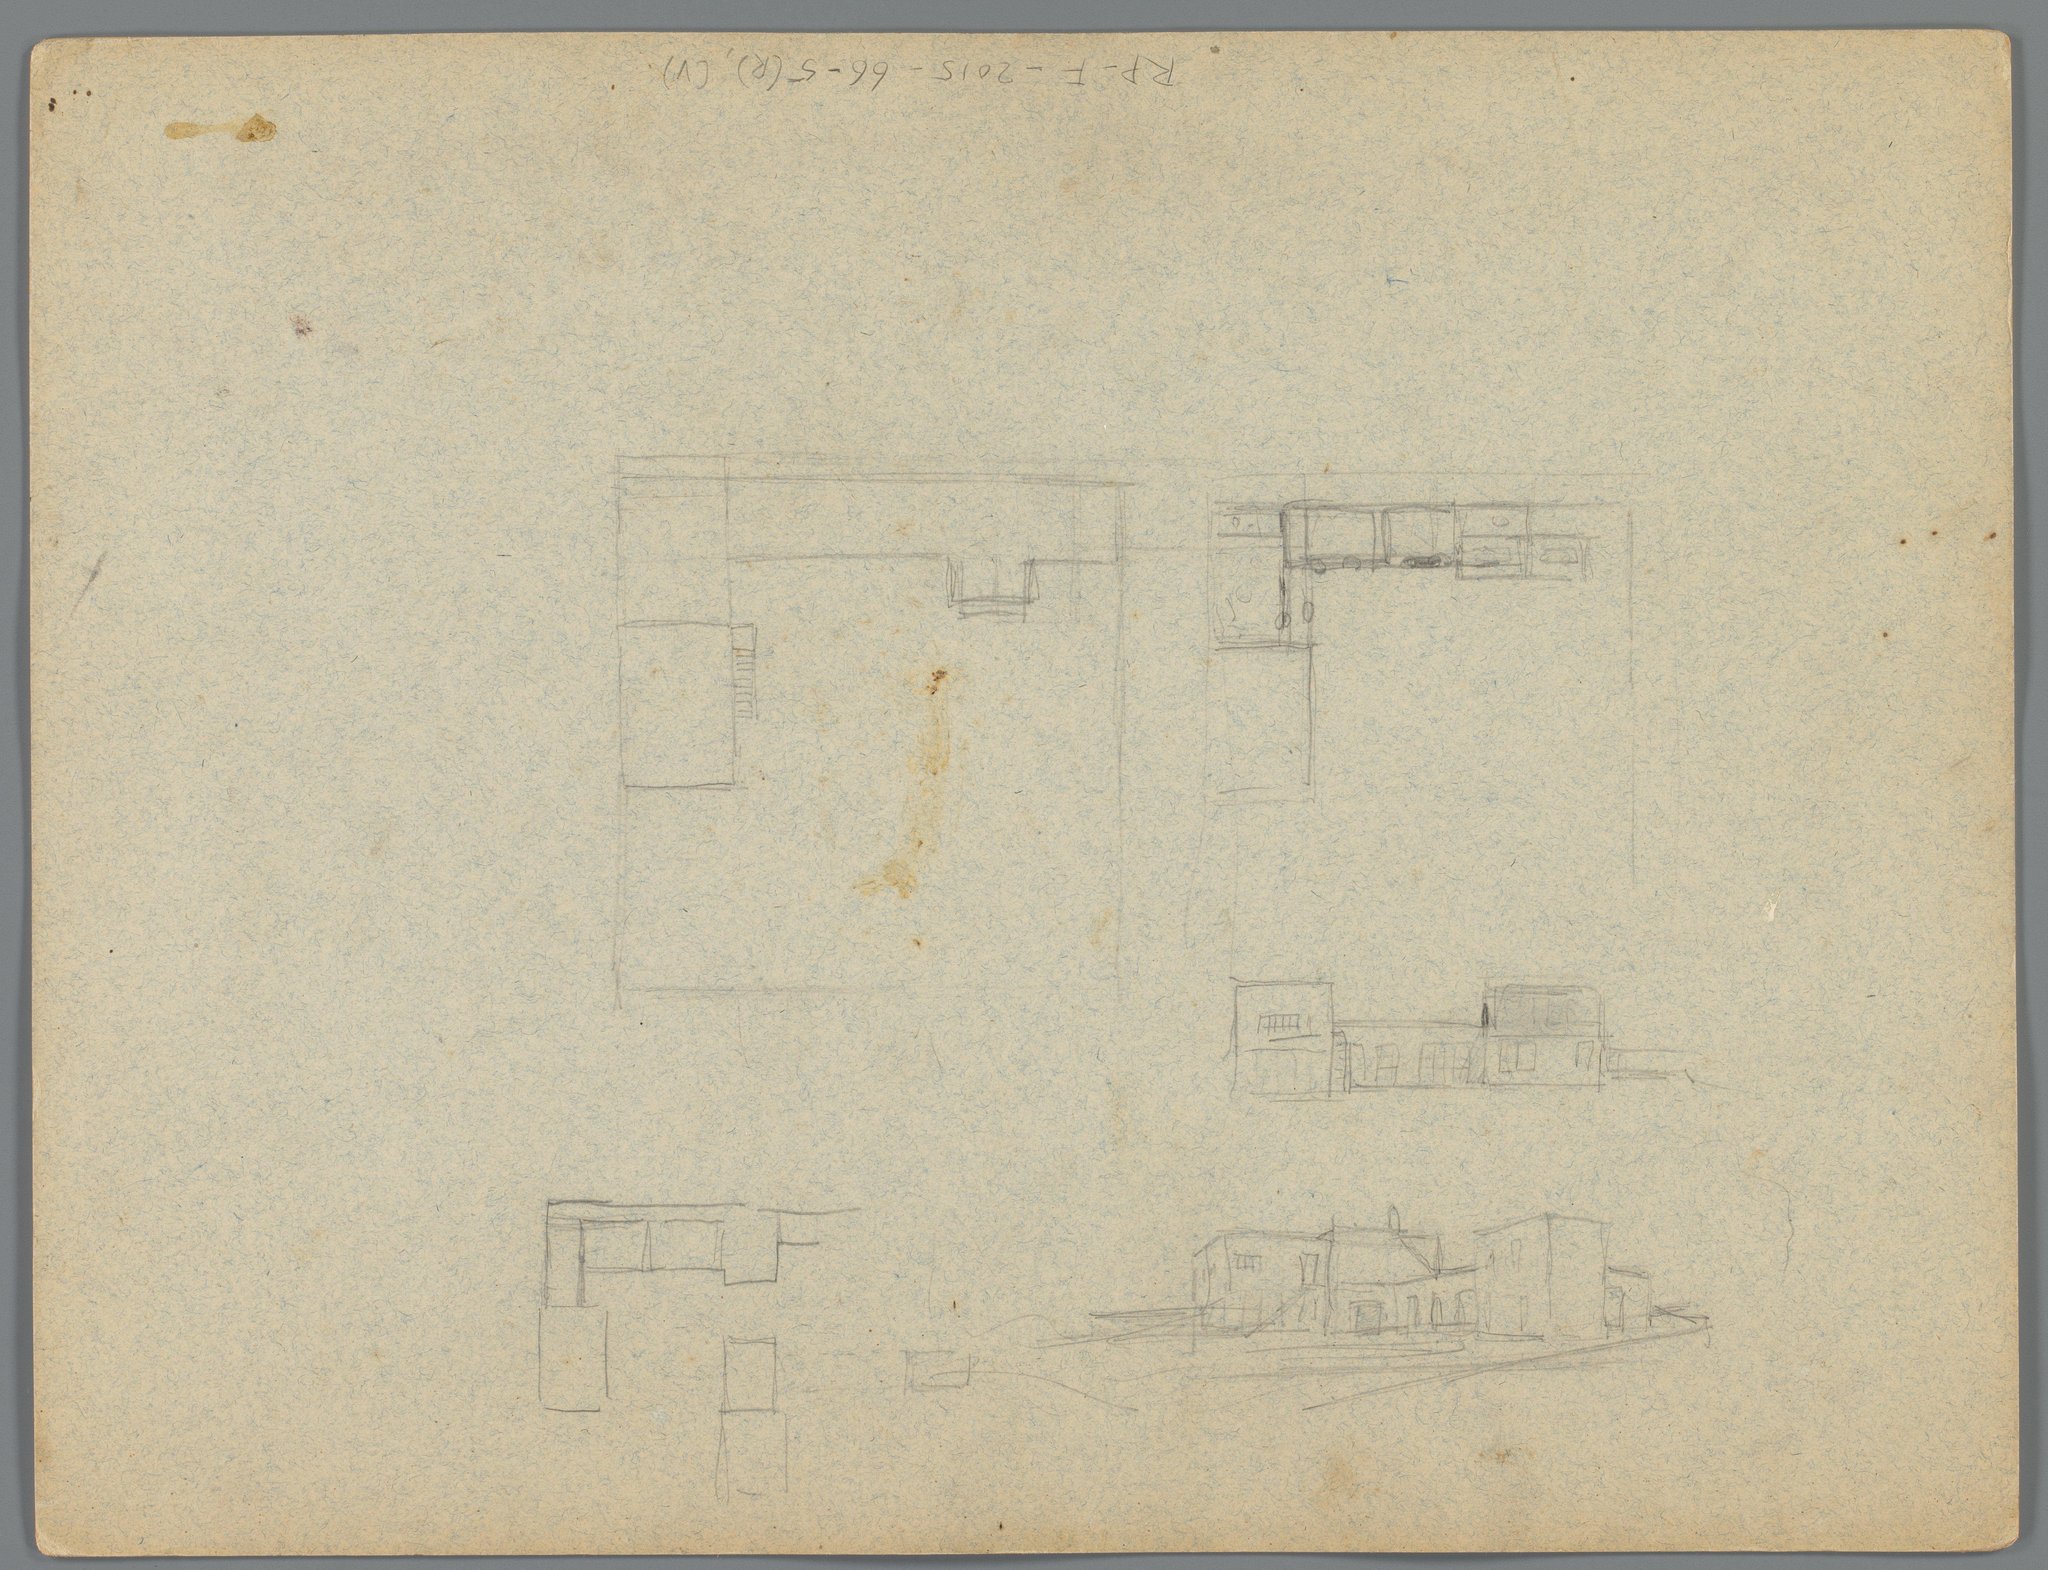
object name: drawing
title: Gebouwencomplex met plattegronden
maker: marius bauer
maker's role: draughtsman, print maker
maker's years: 1867-1932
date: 1890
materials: cardboard, pencil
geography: india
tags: architectural representations in general